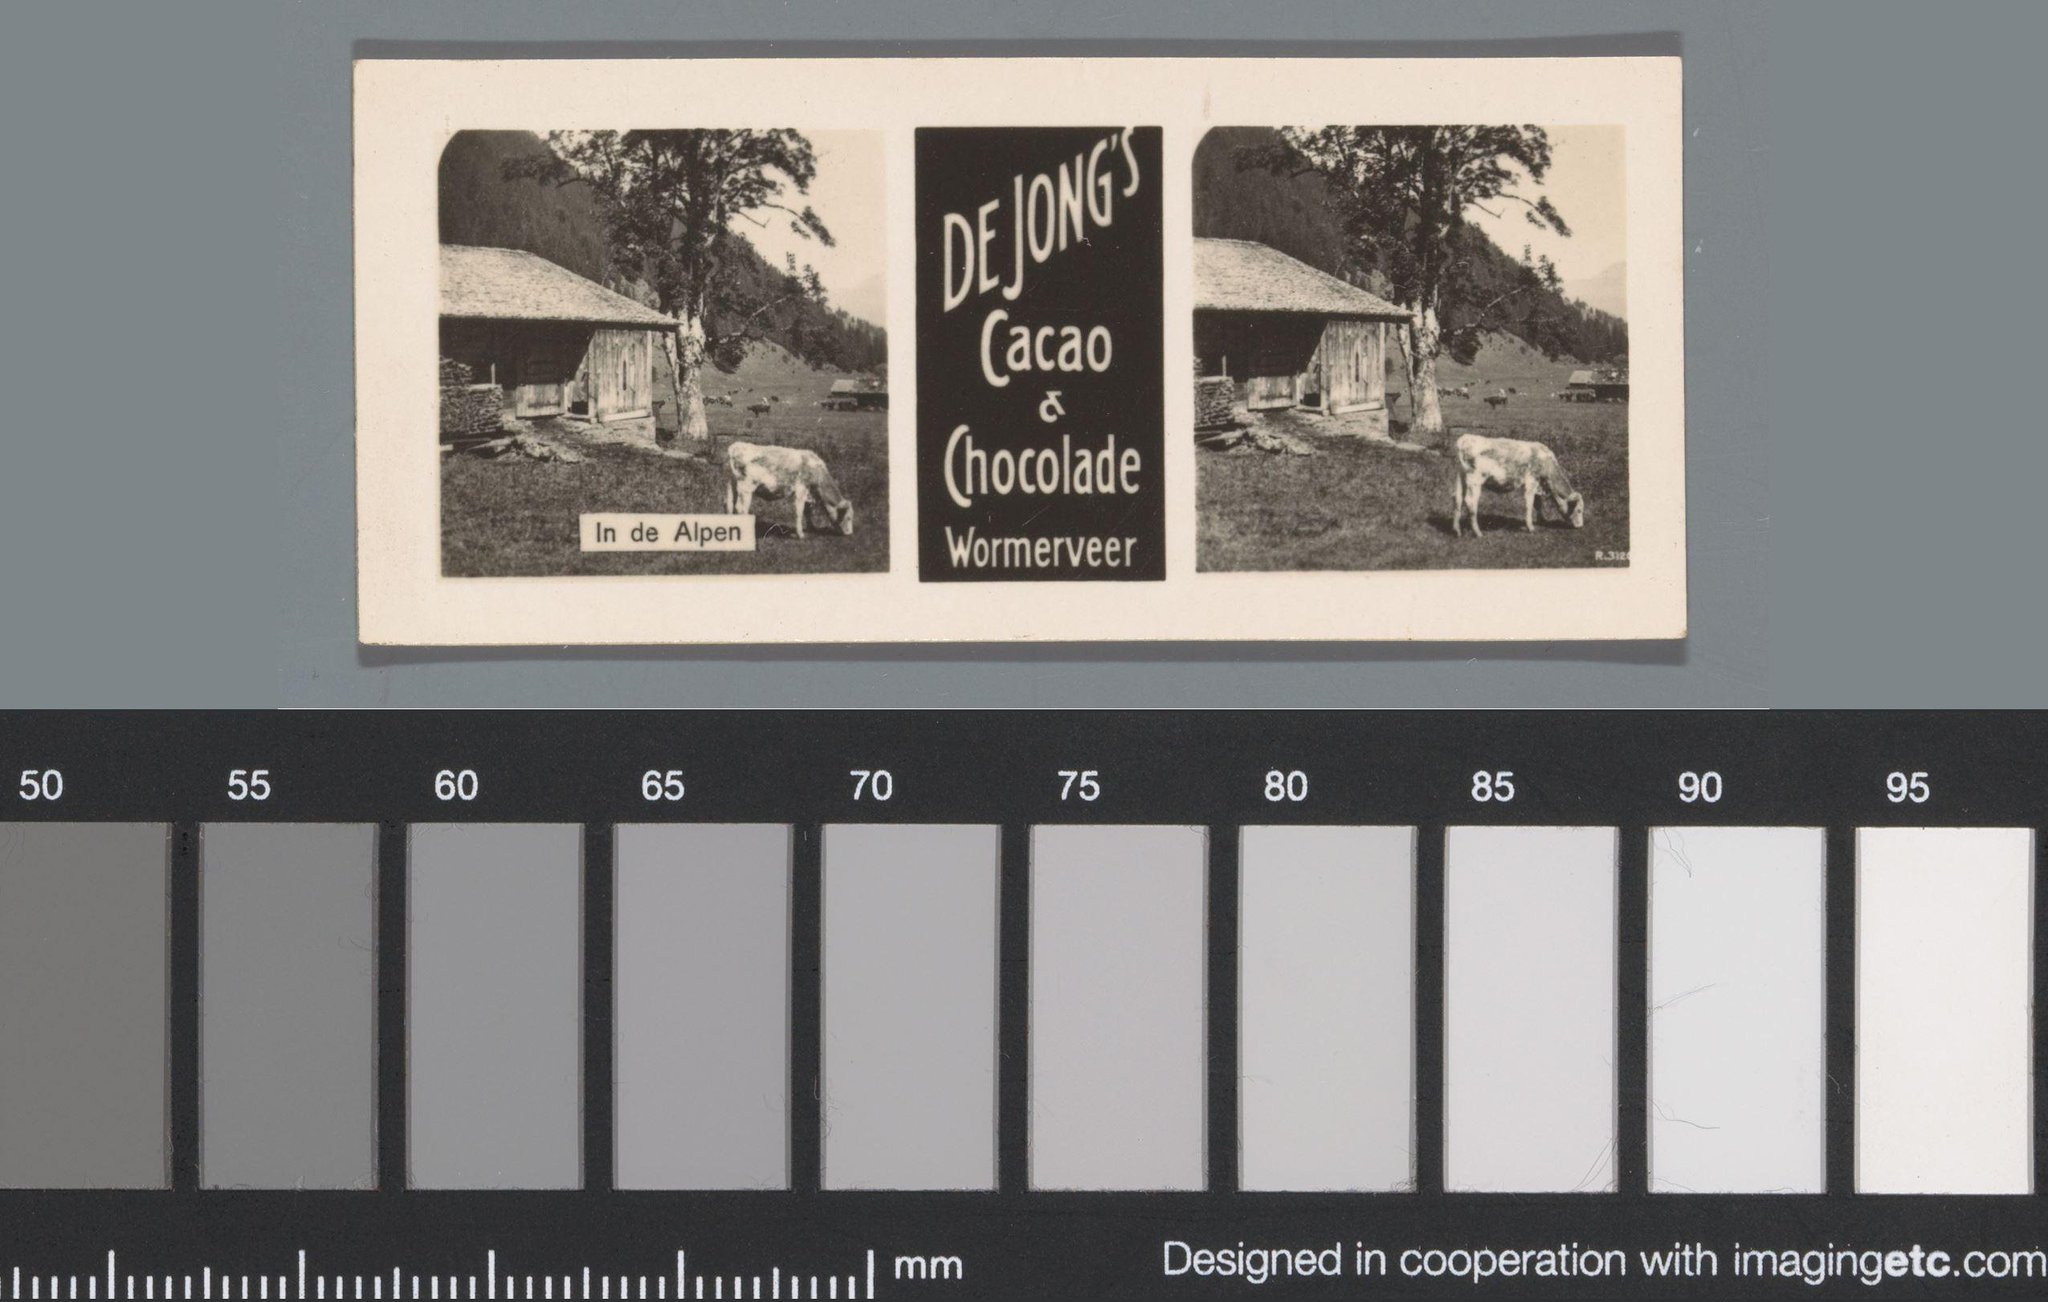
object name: stereograph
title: In de alpen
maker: Anonymous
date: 1900-1910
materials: cardboard, photographic support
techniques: gelatin silver print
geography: alps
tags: façade (of house or building), mountains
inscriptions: inscription: ‘Stereoscoopjes (...) De Jong te Wormerveer.’, inscription: ‘De Jong's Cacao & Chocolade Wormerveer’